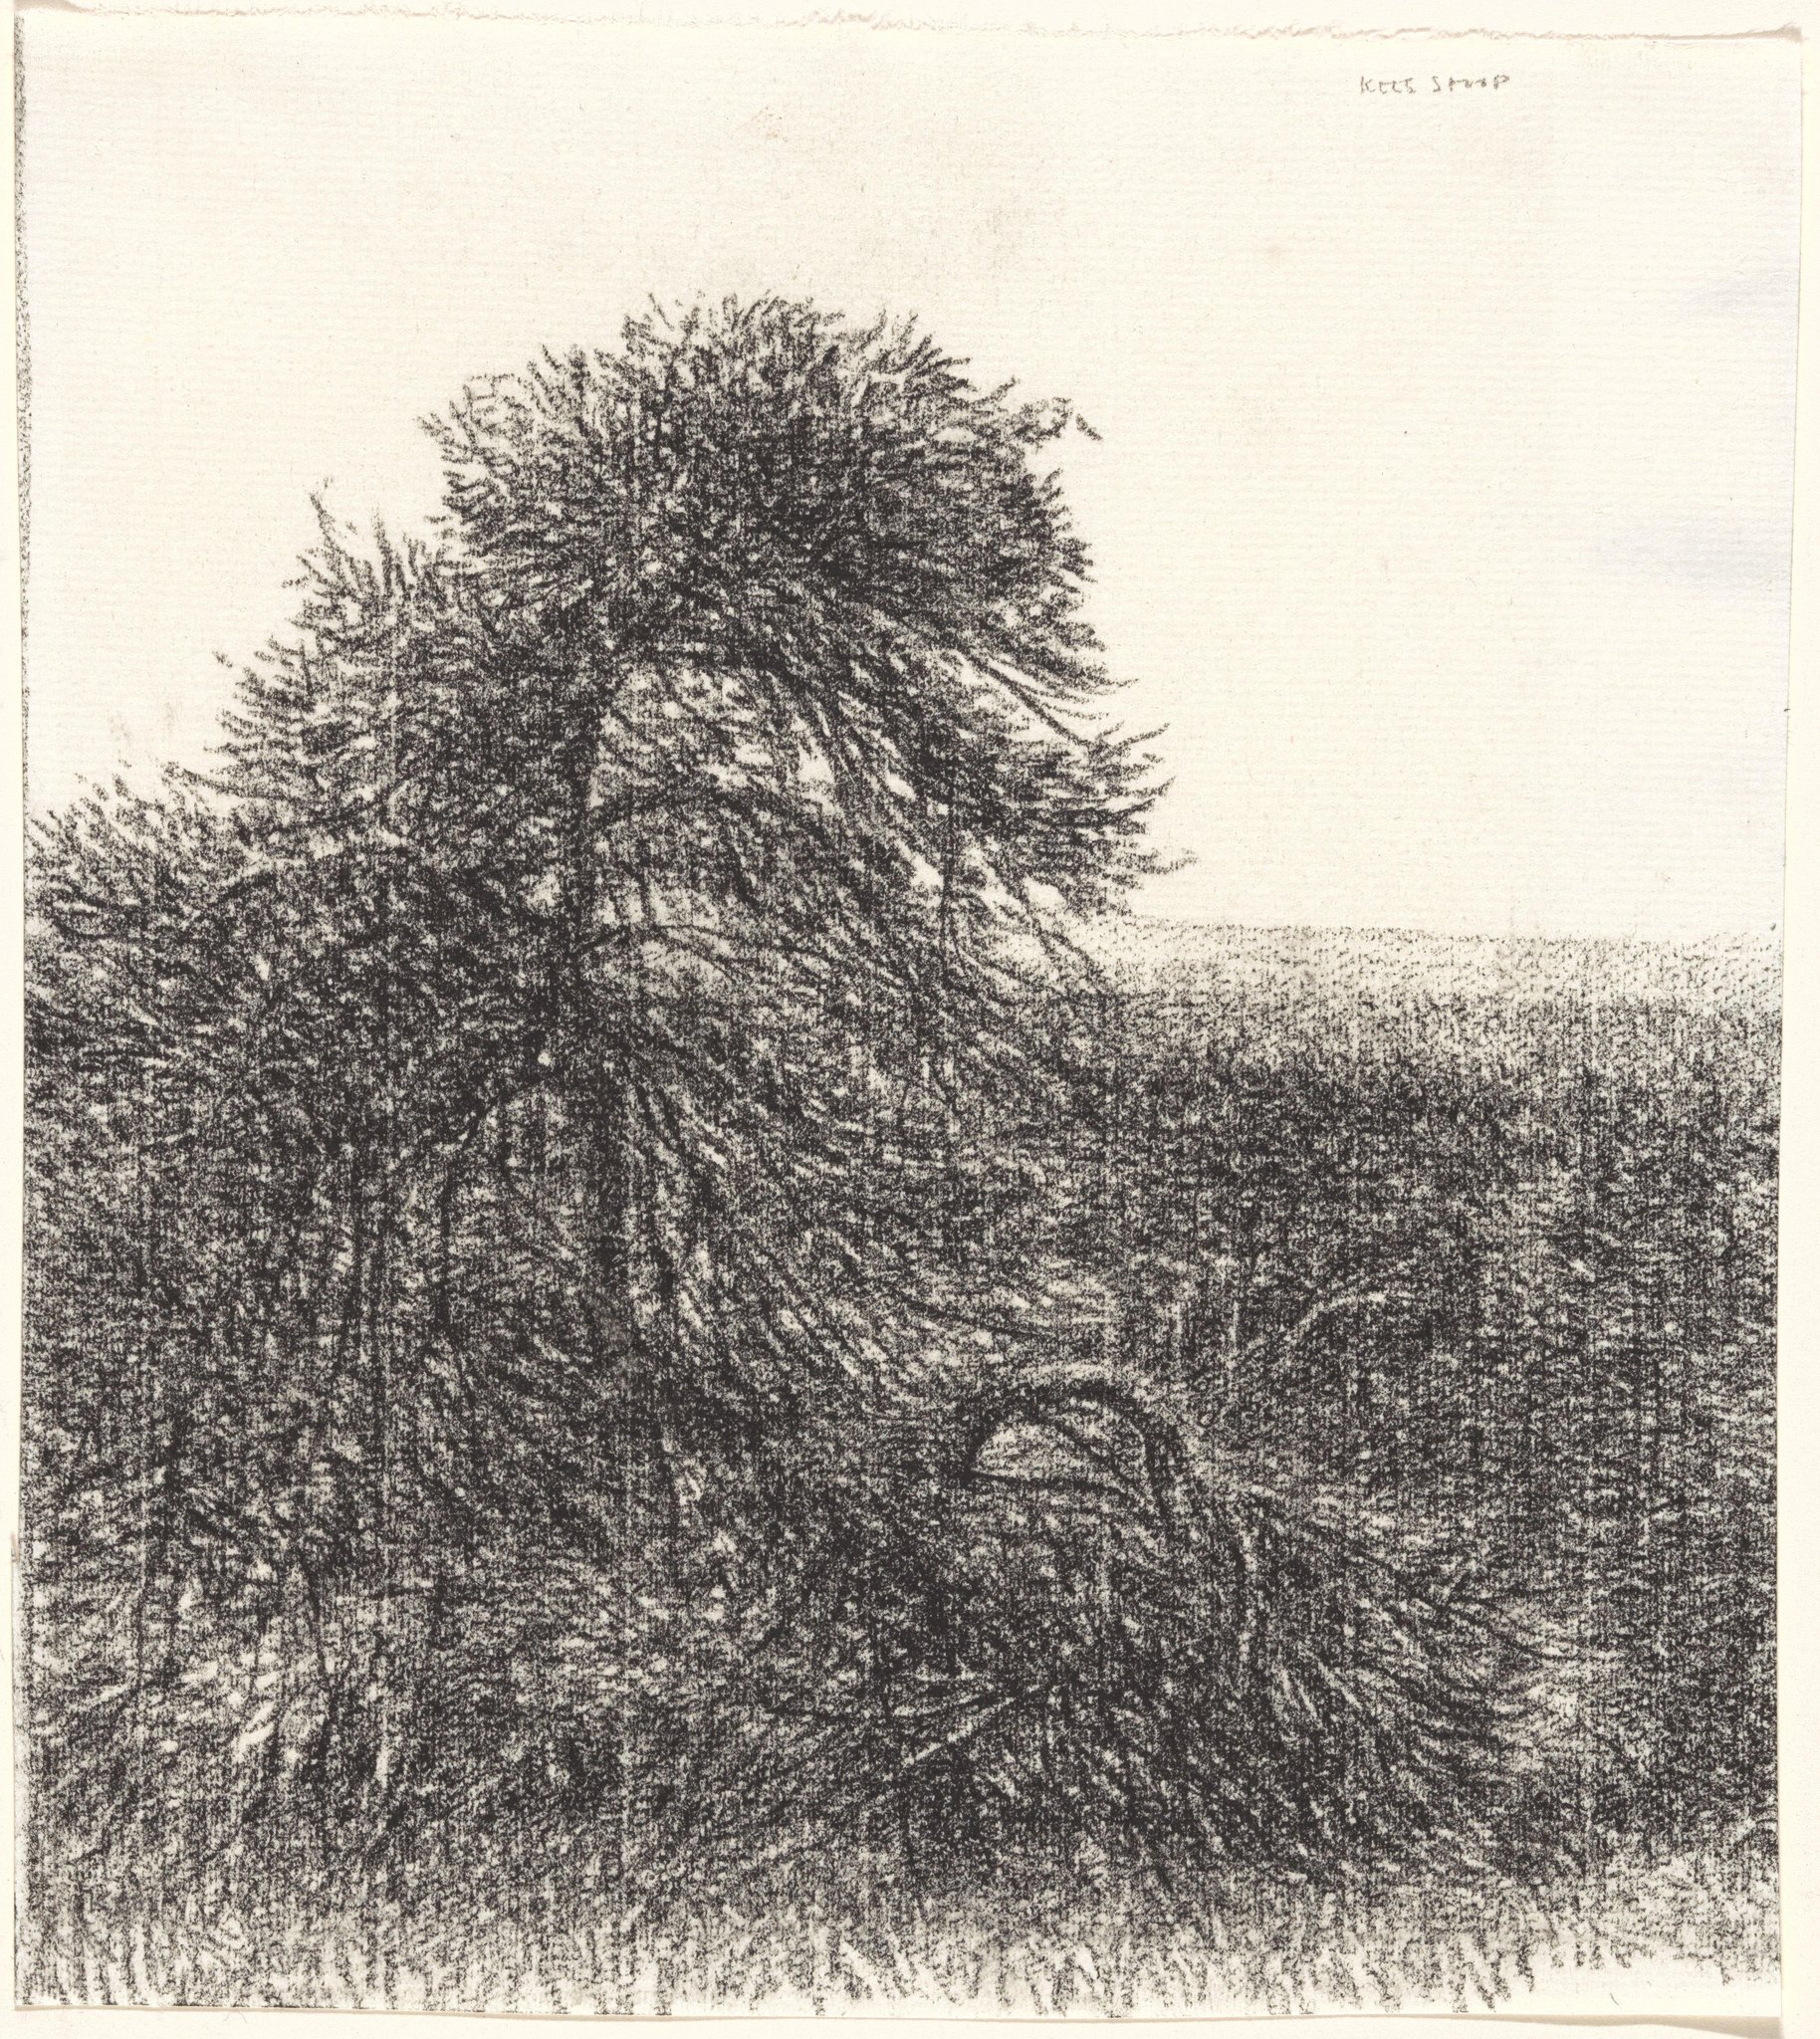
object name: drawing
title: Boom in vlak landschap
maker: kees stoop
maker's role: draughtsman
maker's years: 1929-2019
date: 1939-2009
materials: charcoal, paper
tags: groups of trees